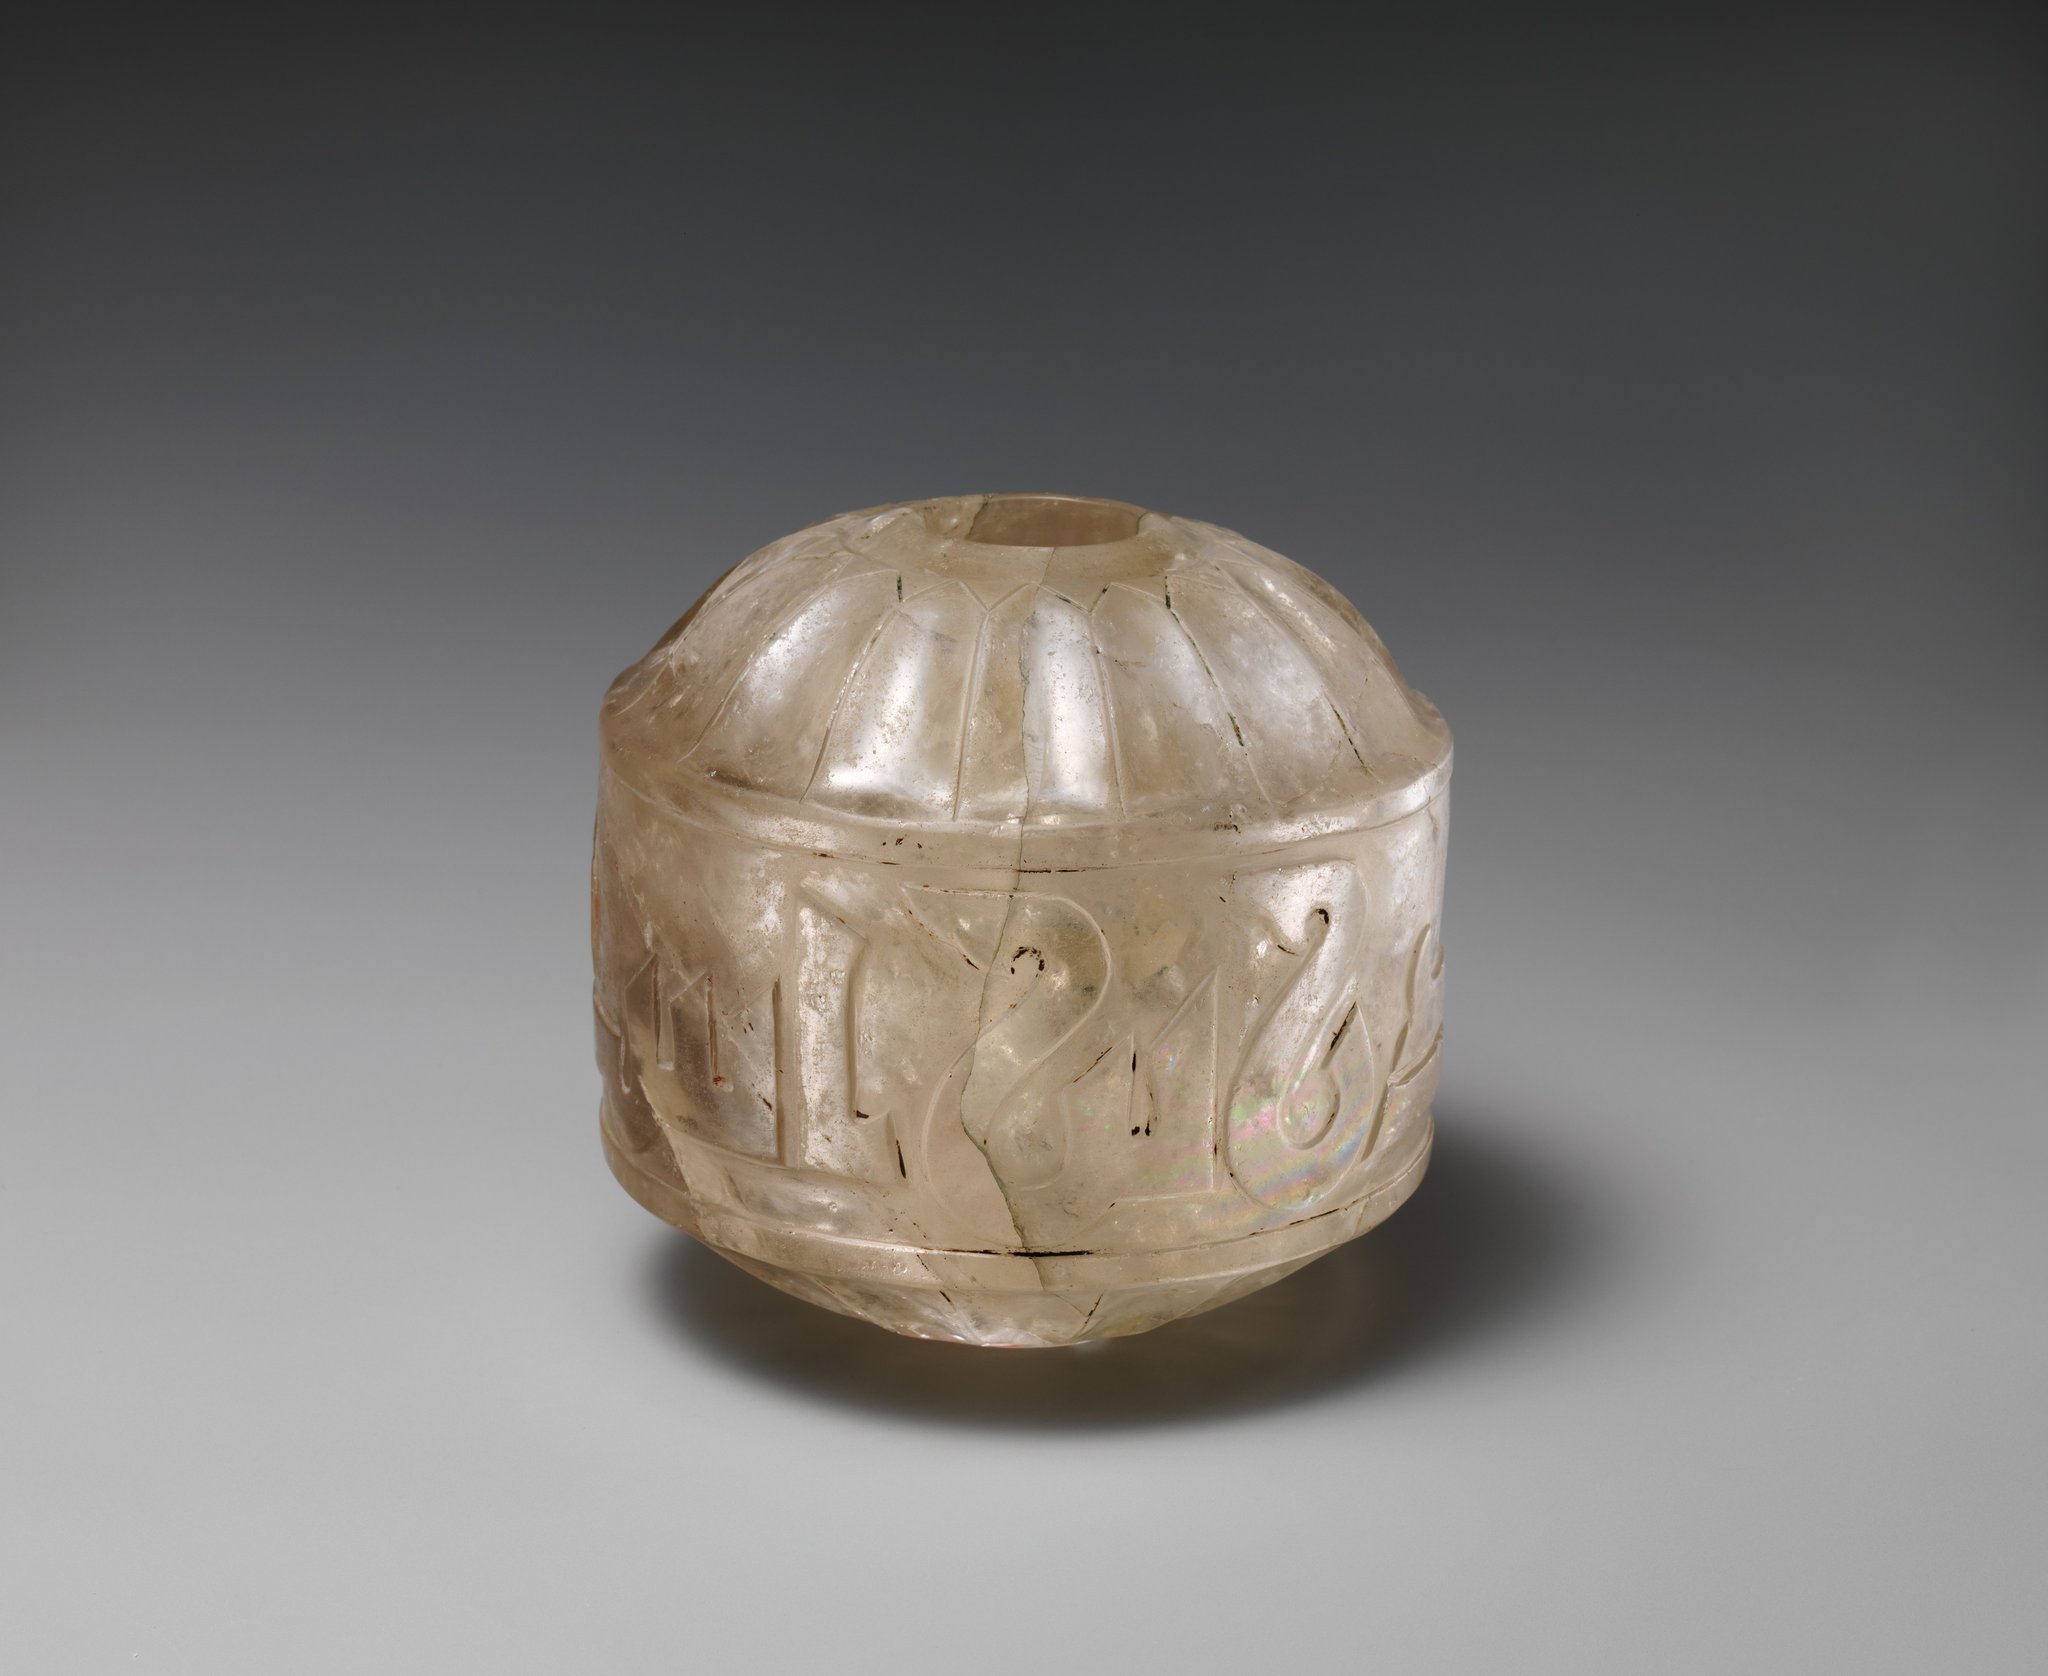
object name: mace head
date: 1467-1500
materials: quartz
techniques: carving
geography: iran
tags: military equipment